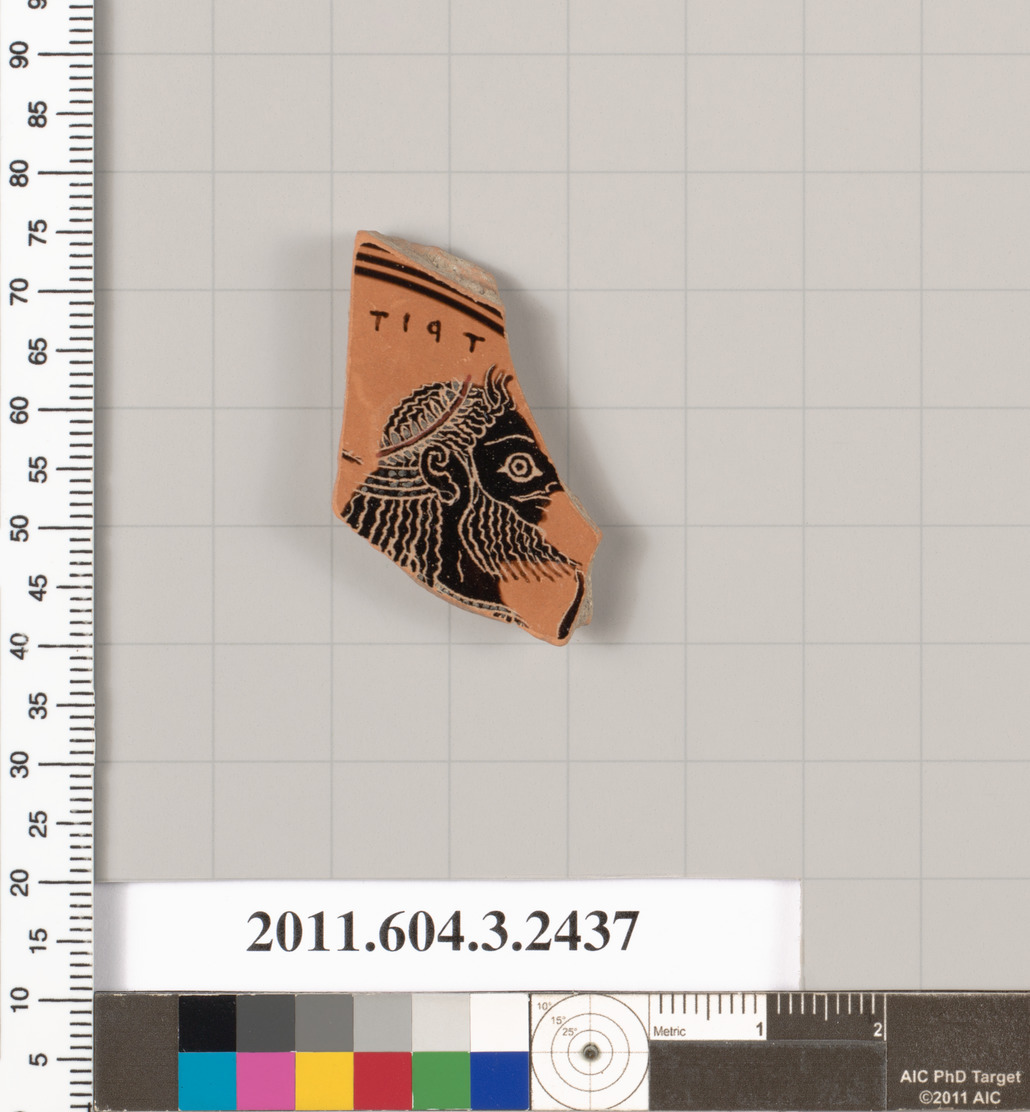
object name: kylix fragment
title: Terracotta fragment of a kylix (drinking cup)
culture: greek, attic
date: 550-526 BCE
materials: terracotta